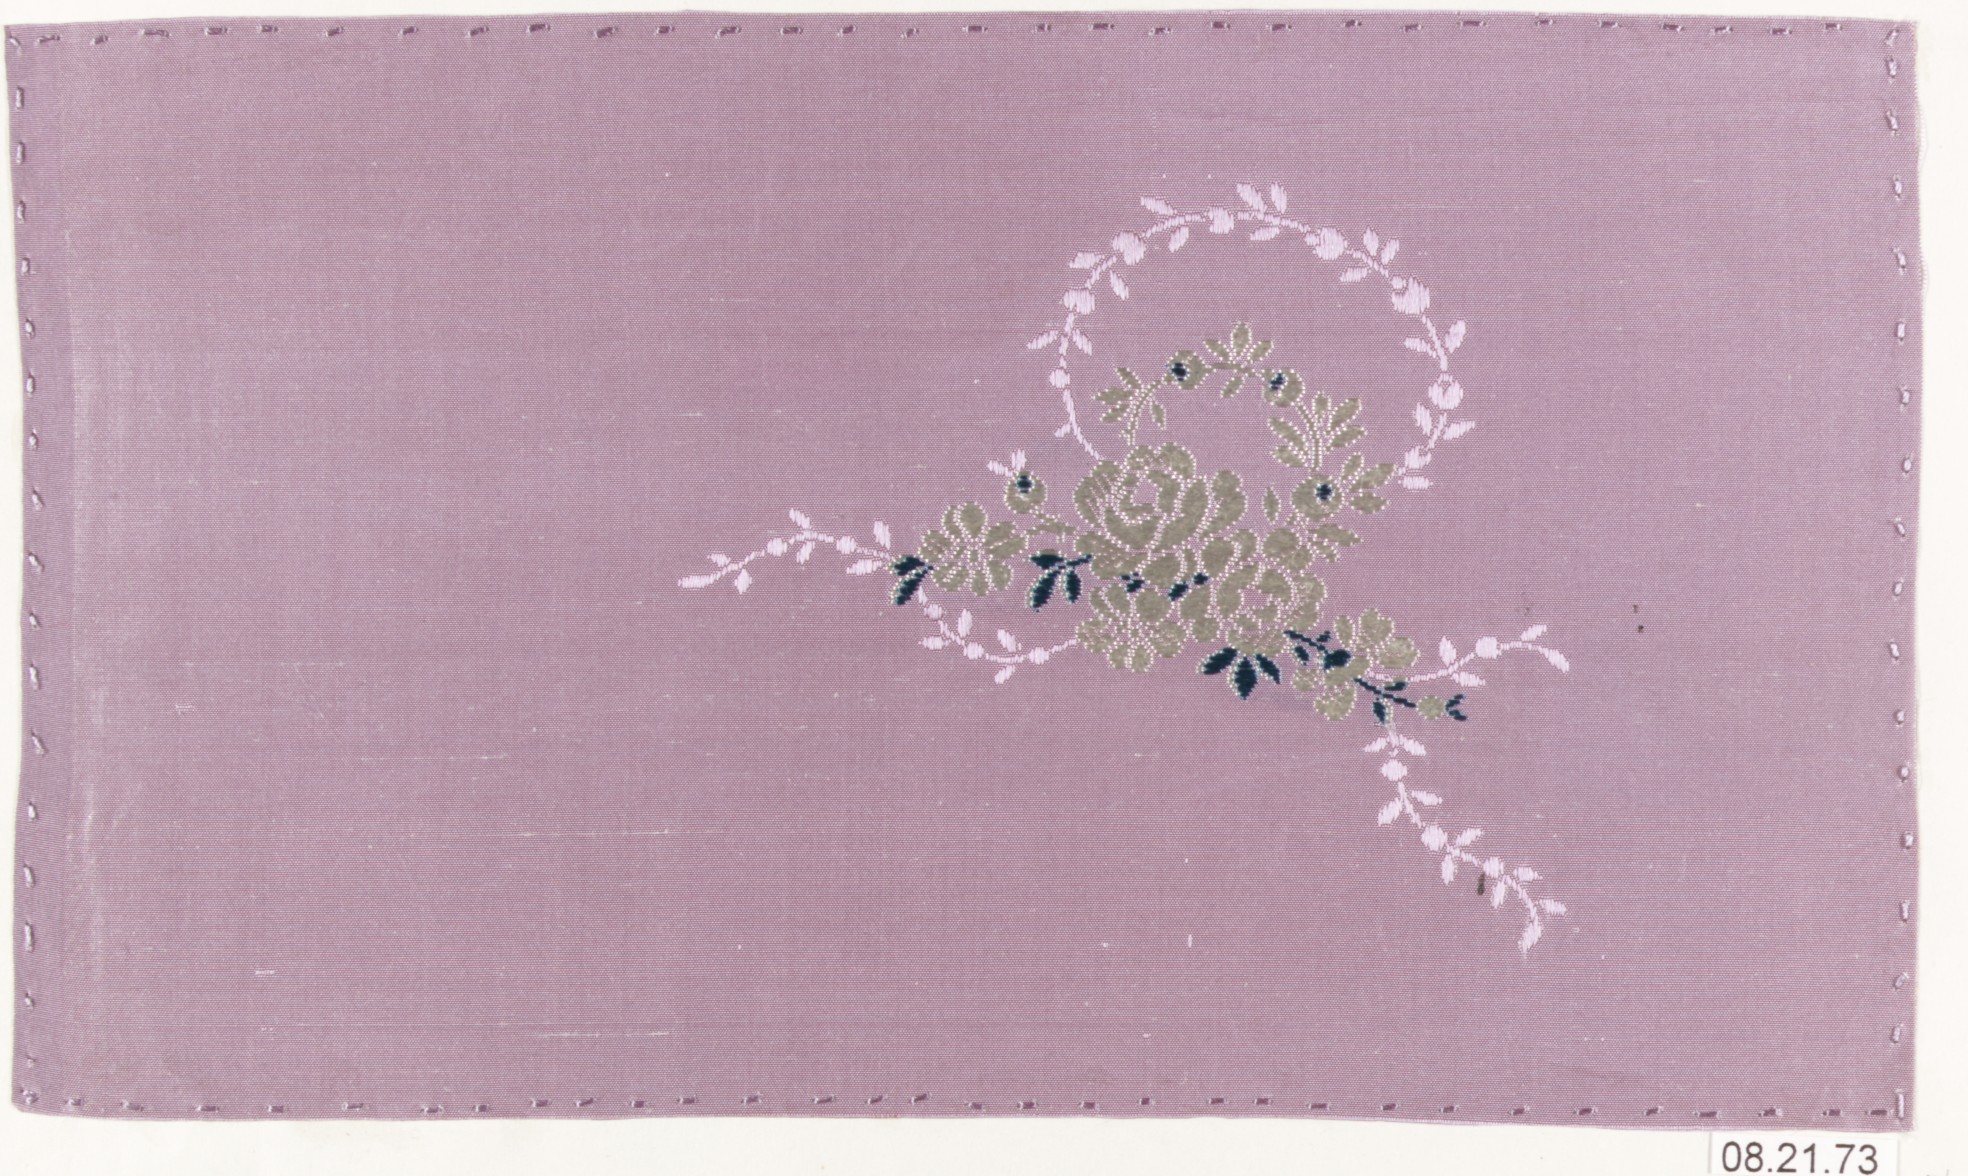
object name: textile sample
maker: Anonymous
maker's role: designer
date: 1900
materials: silk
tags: flowers